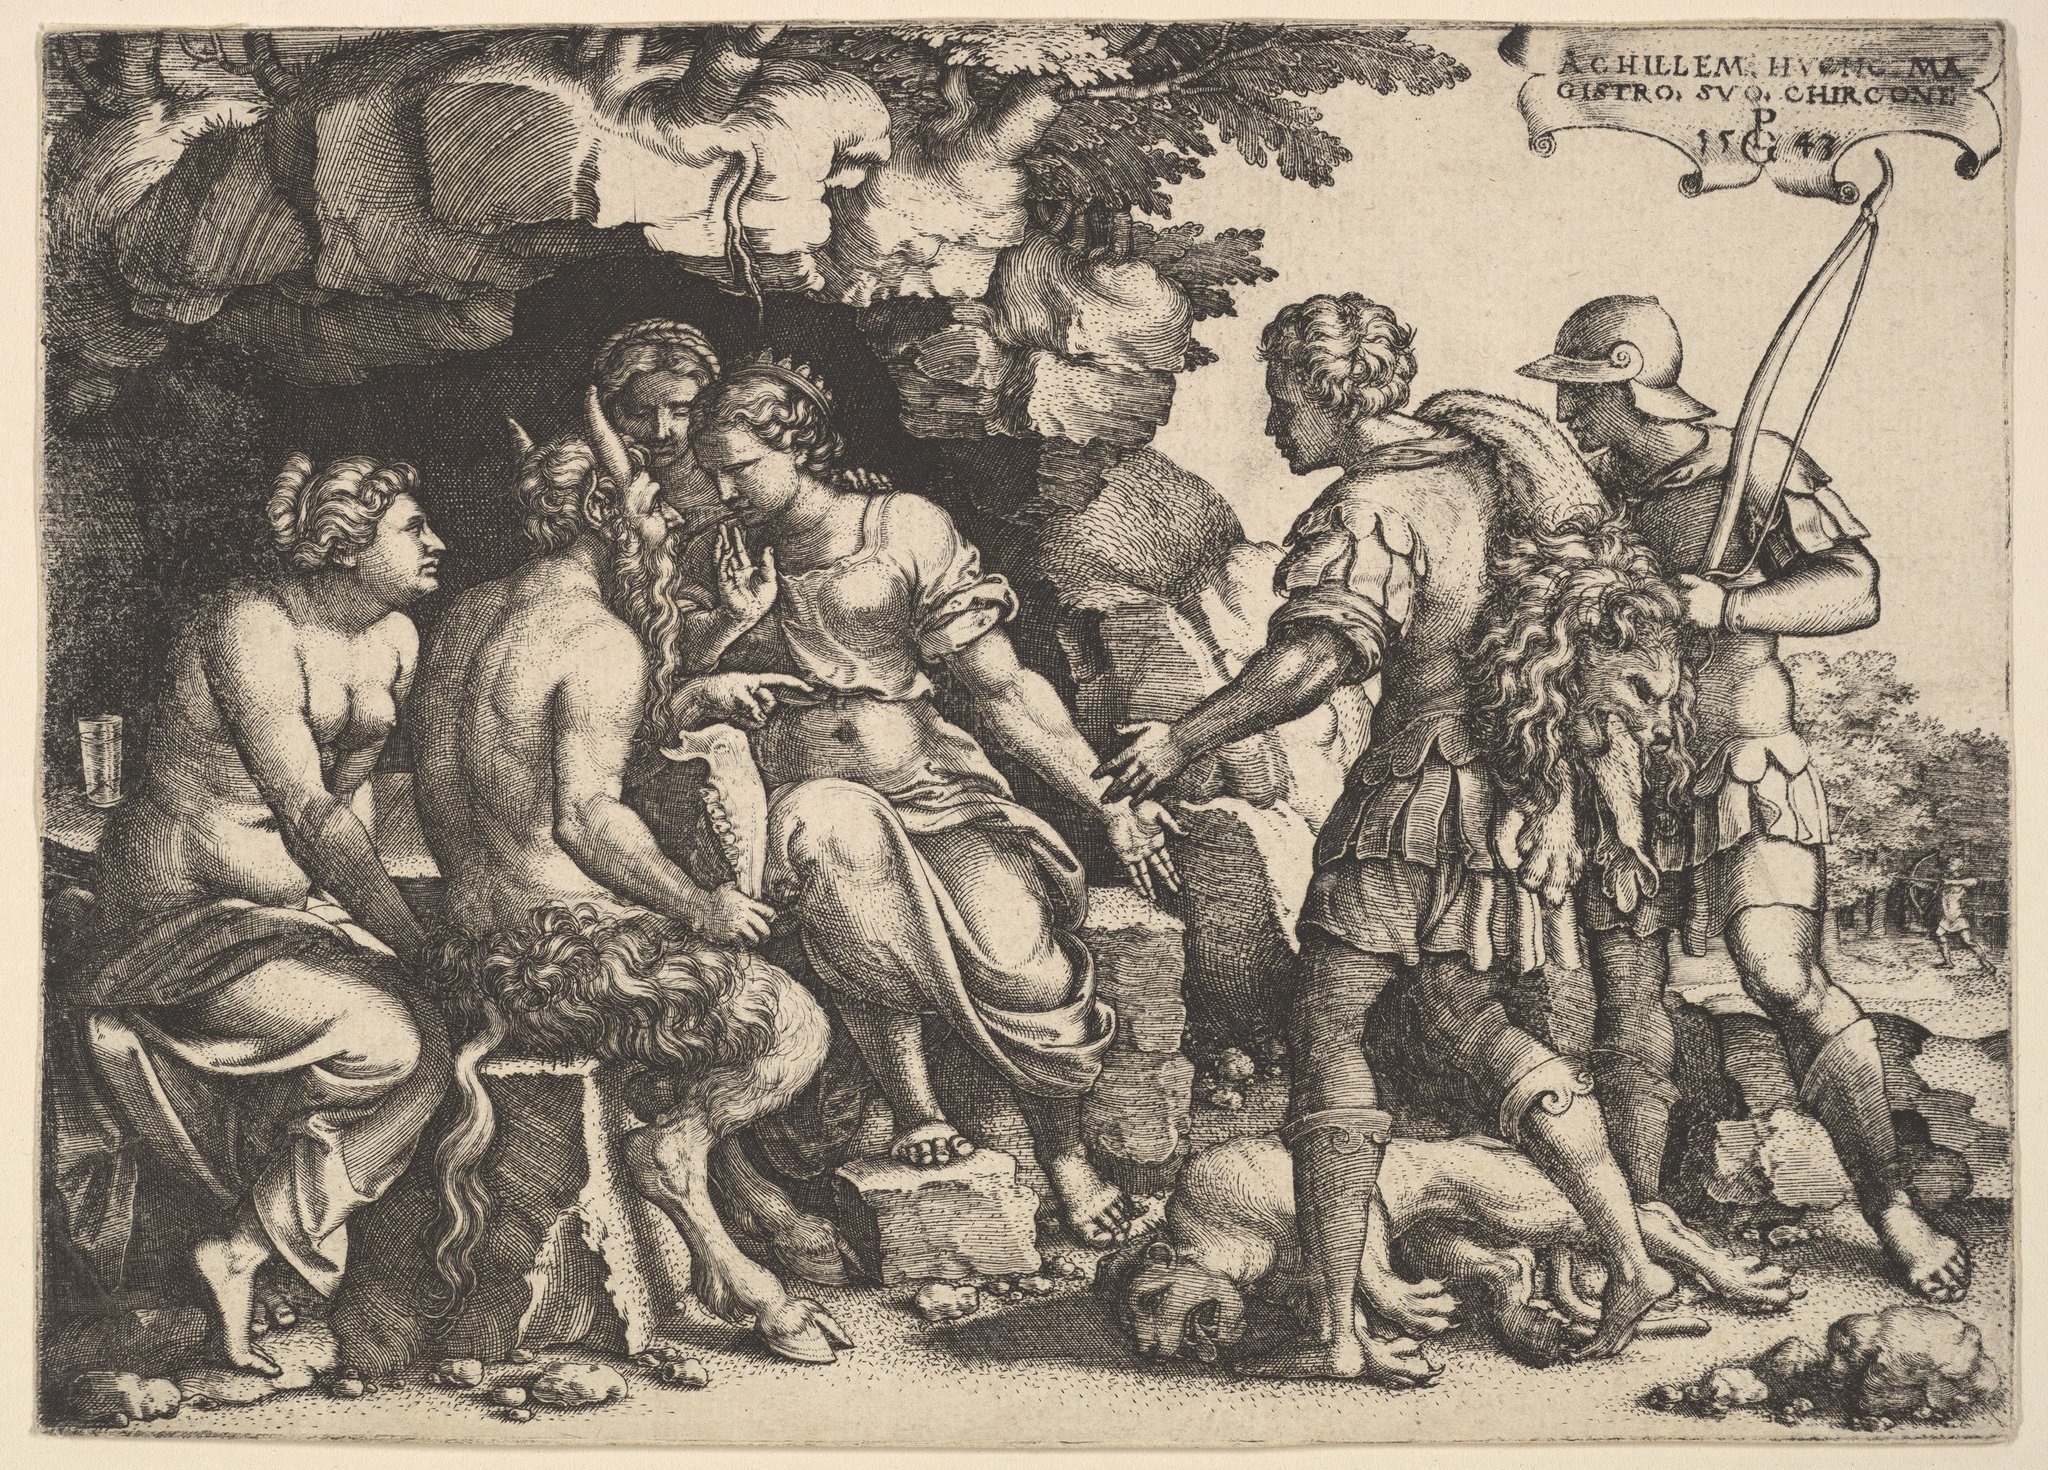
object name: print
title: Thetis and Chiron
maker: georg pencz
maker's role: artist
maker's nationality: german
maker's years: 1500-1550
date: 1543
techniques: engraving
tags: men,women